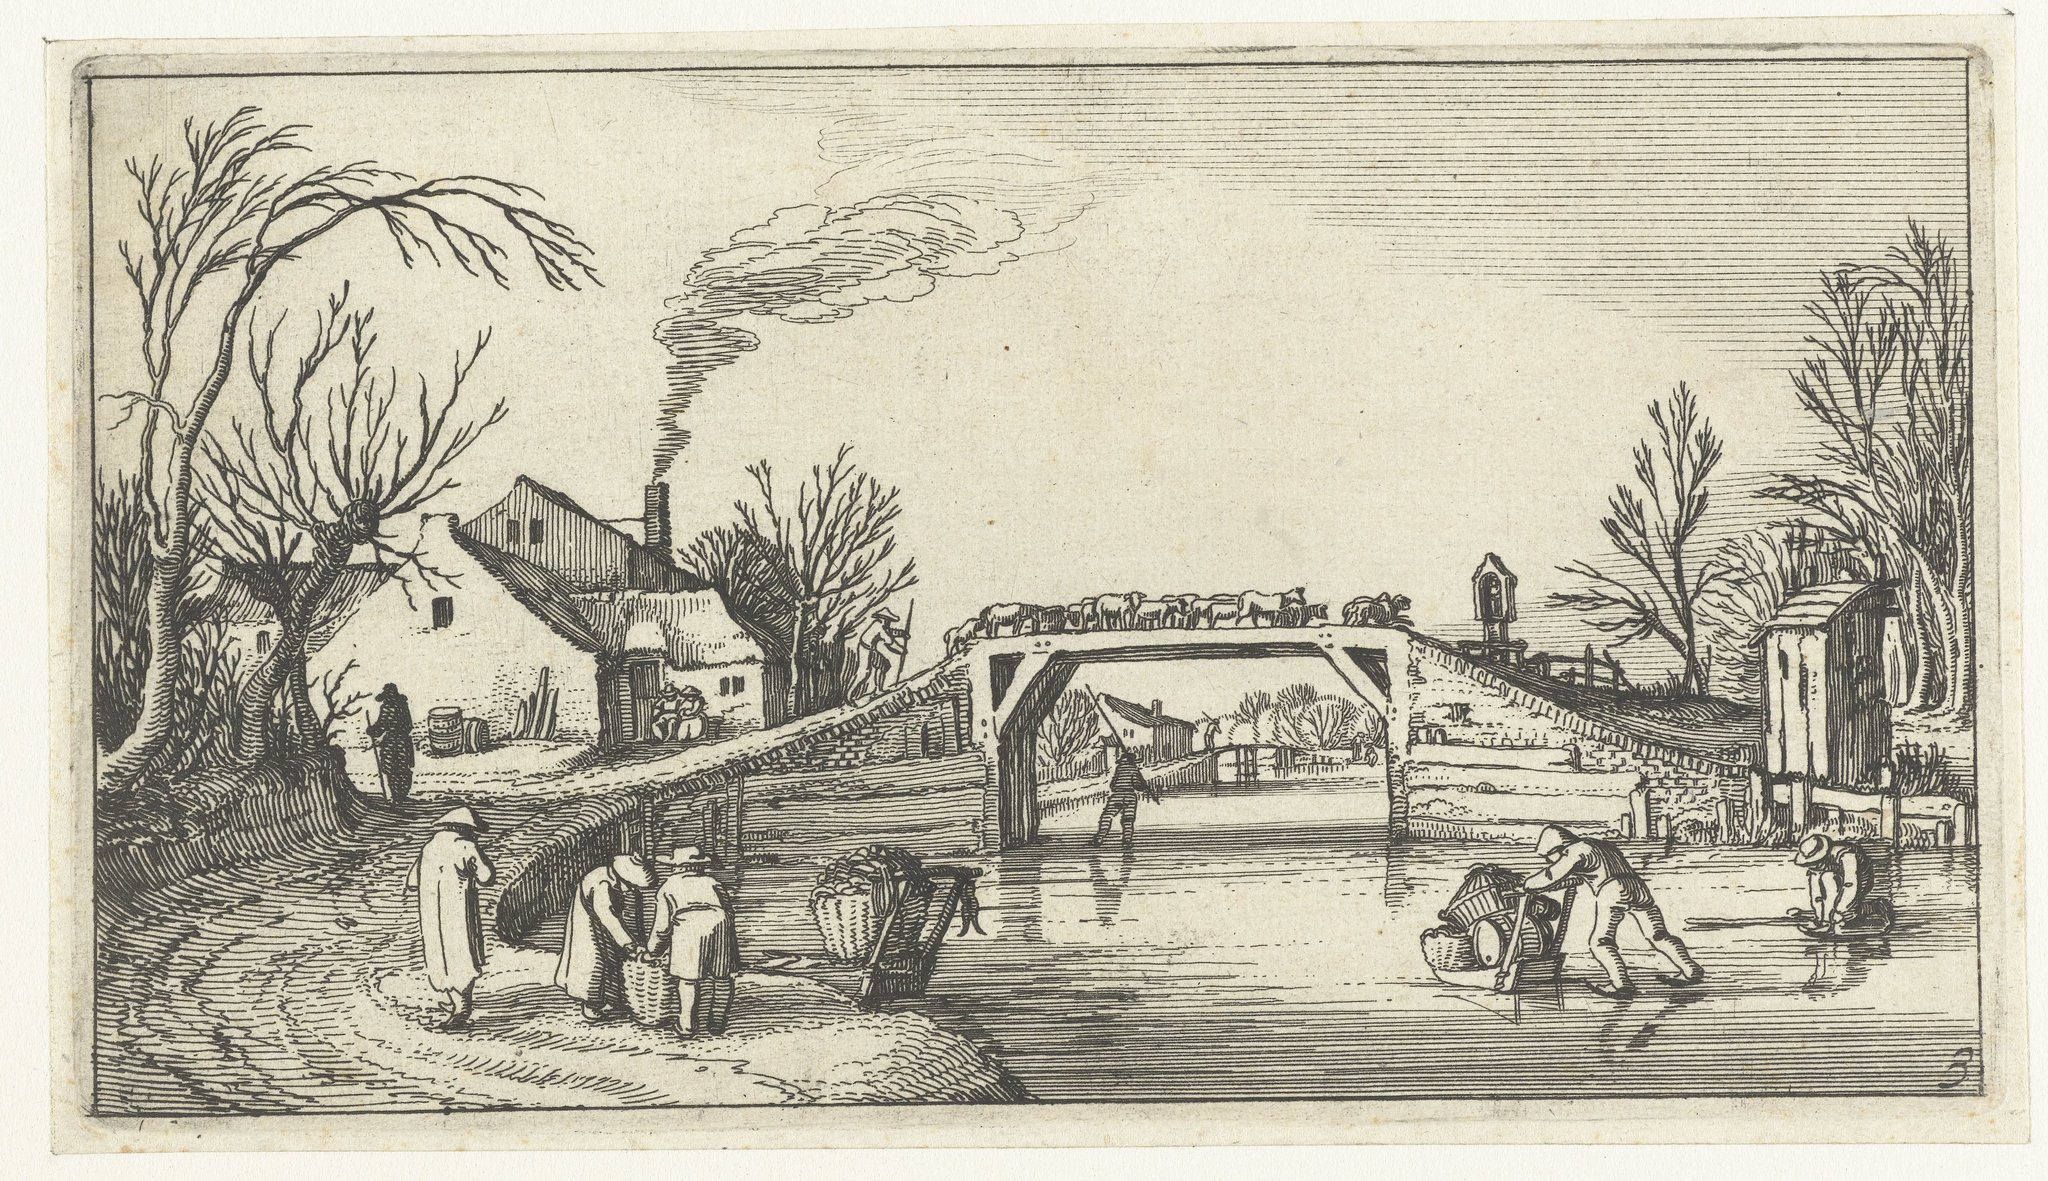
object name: print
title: Landschappen naar Esaias van de Velde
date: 1610-1650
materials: paper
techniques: etching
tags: landscape with bridge, viaduct or aqueduct, skates (winter sports), farm or solitary house in landscape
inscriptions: collector's mark: Lugt 2228a